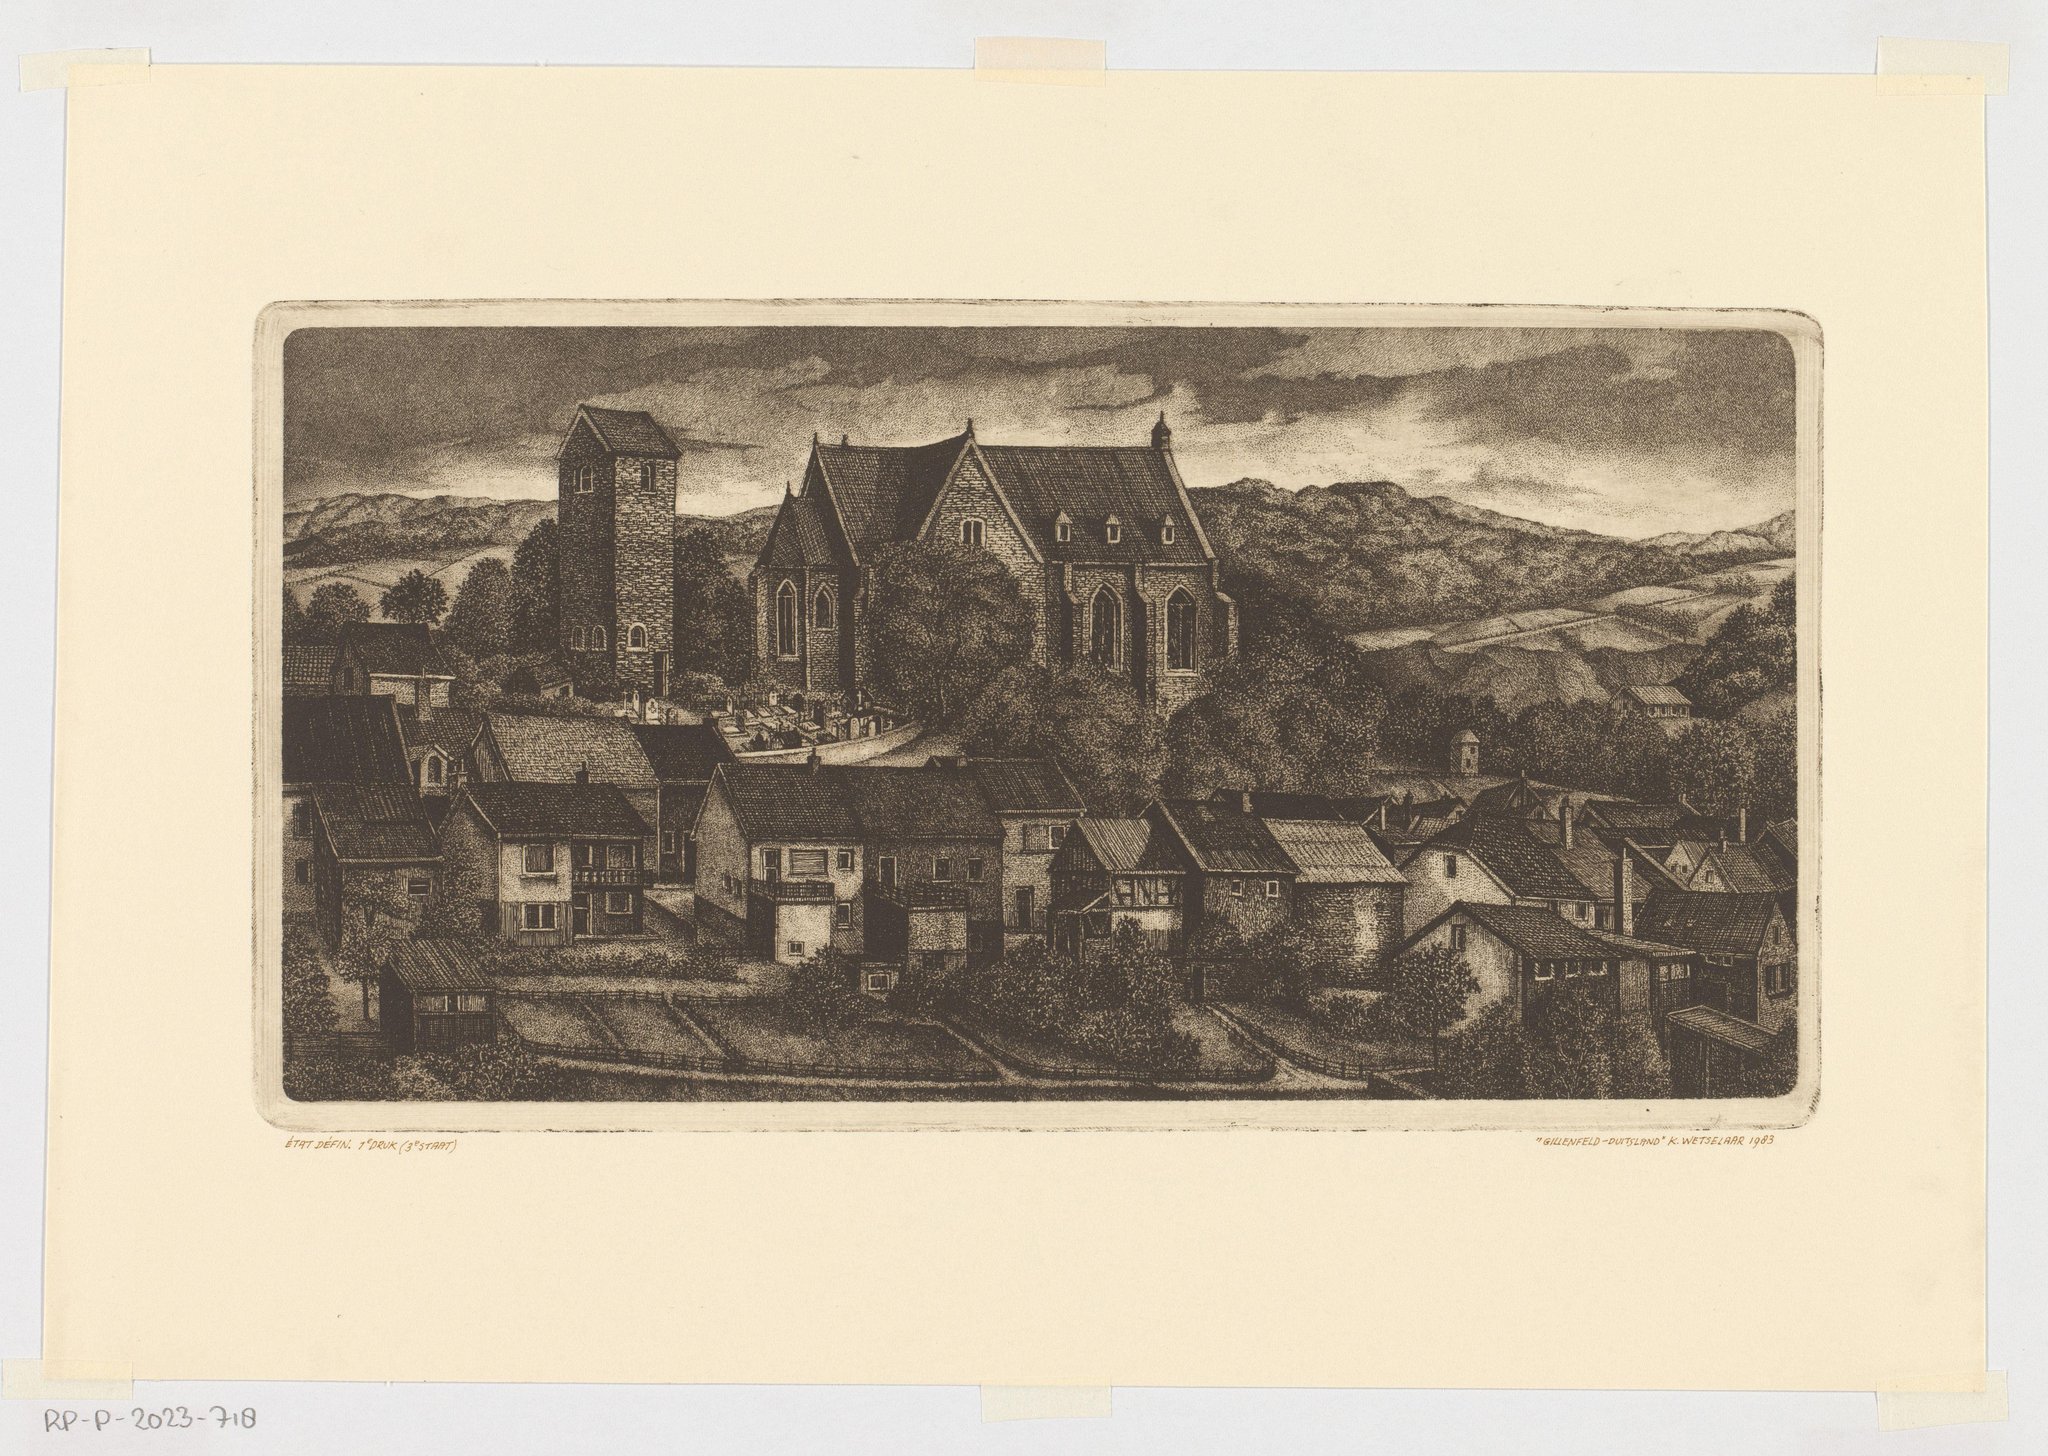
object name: print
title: Gillenfeld - Duitsland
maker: karel wetselaar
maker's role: print maker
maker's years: 1935-2017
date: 1983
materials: paper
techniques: etching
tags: village, church (exterior), churchyard, cemetery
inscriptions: inscription: ‘état défin. 1e druk (3e staat)’, signature and date: ‘K. Wetselaar 1983’